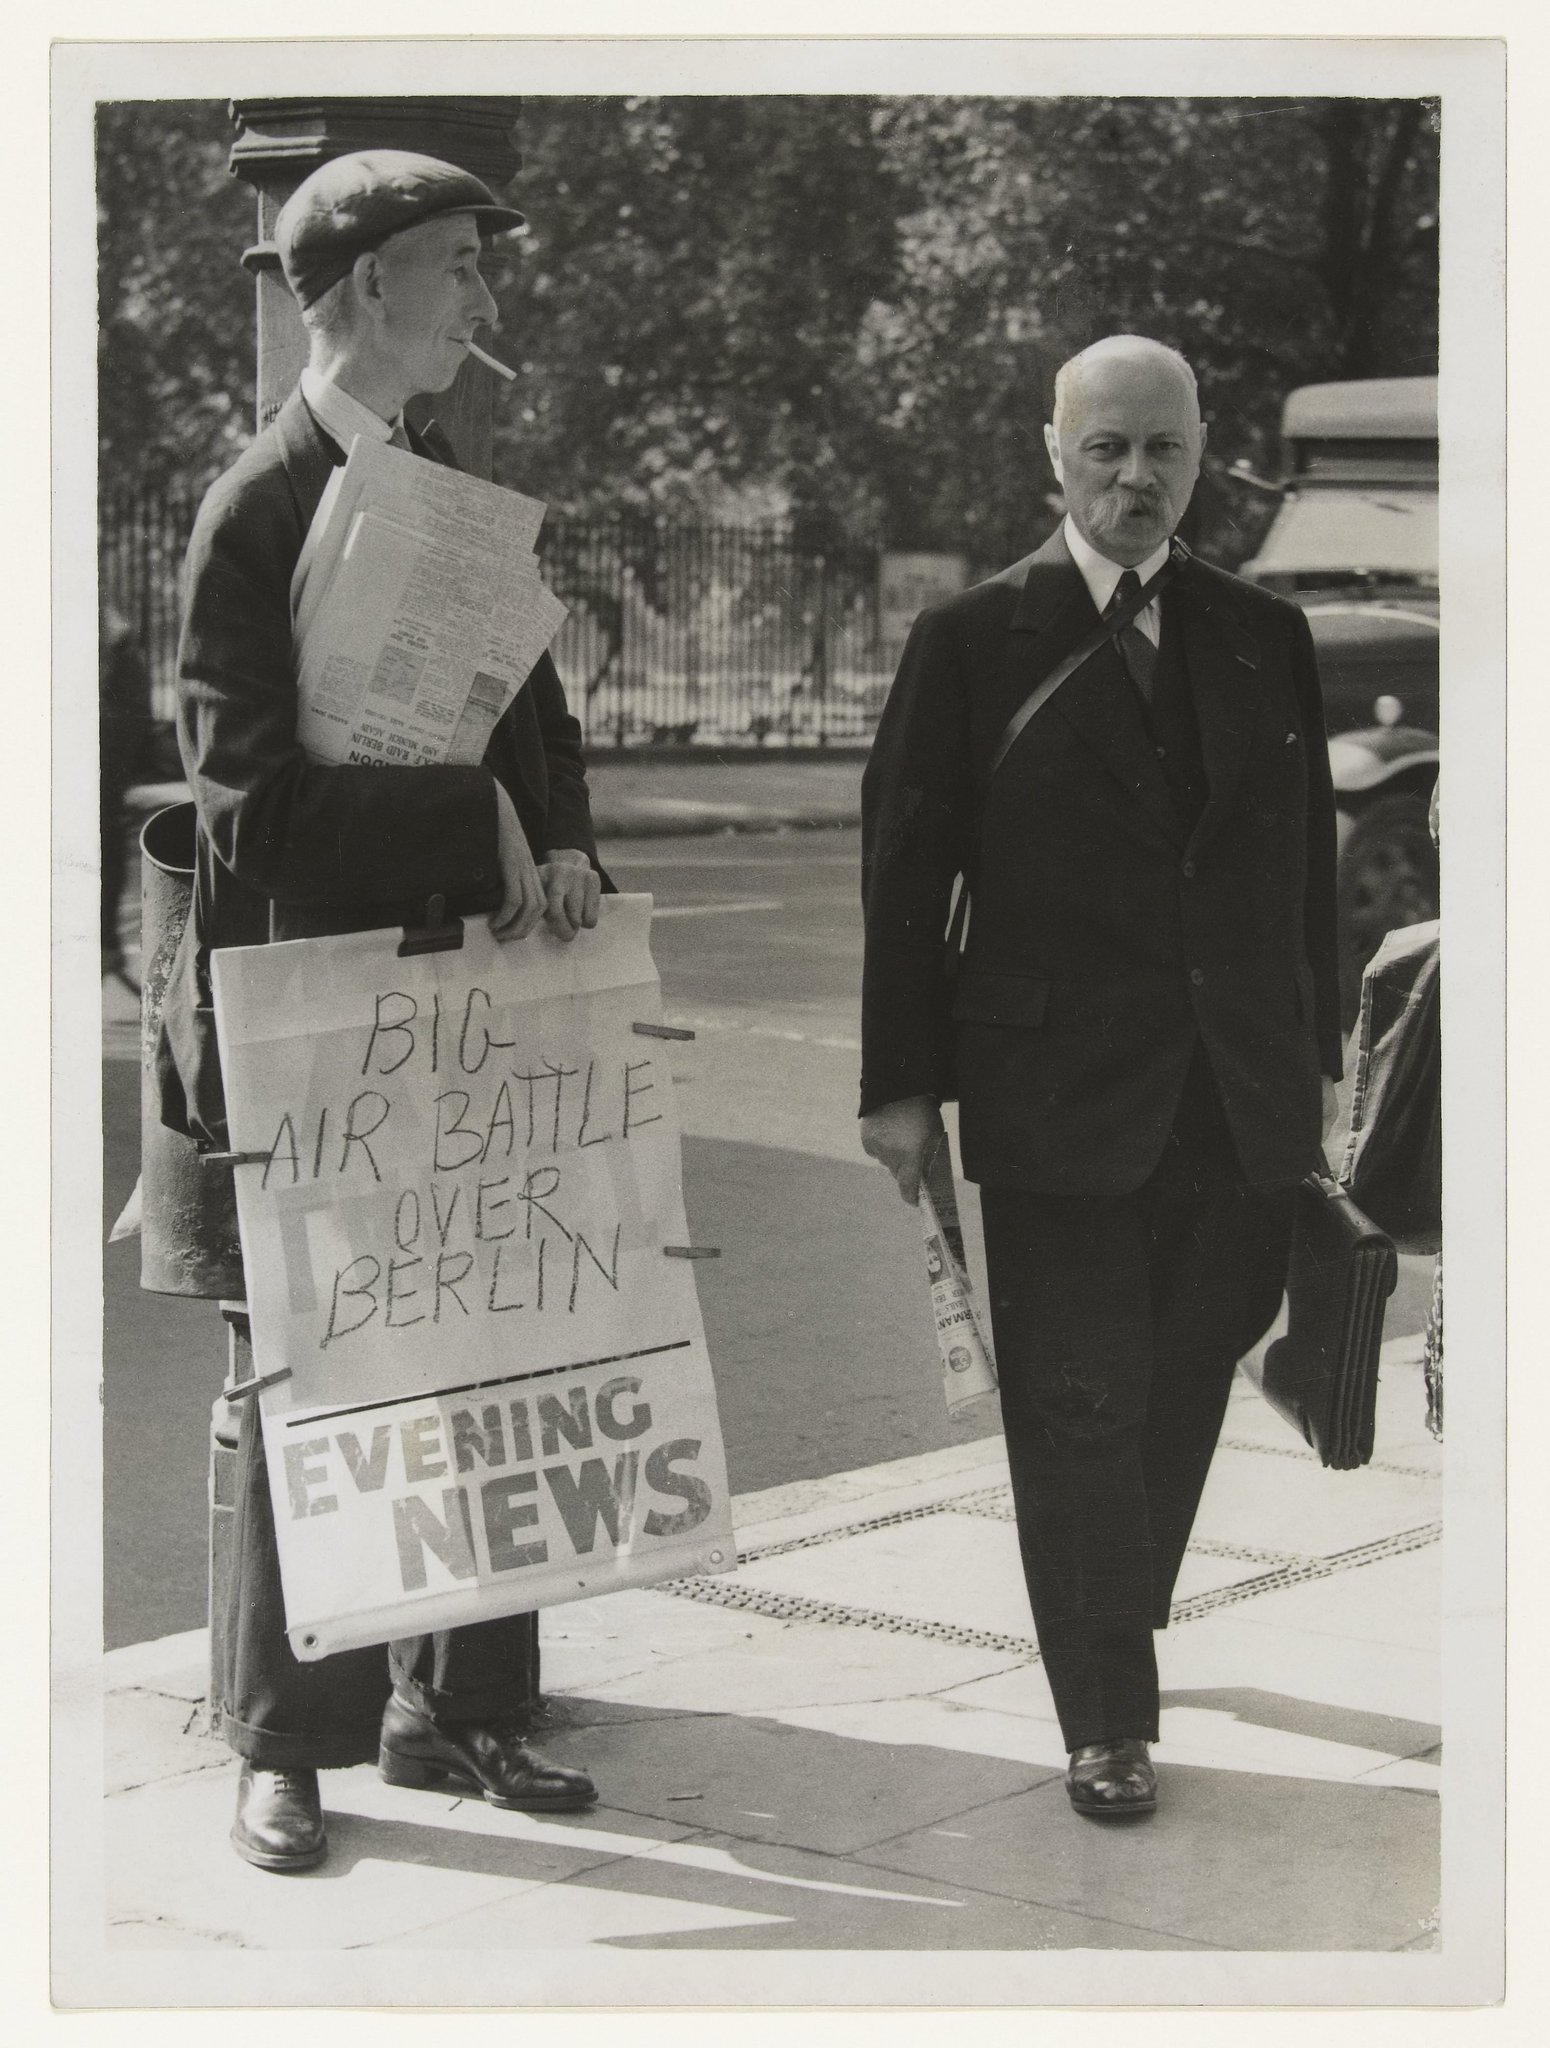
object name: documentary photograph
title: De kersverse premier Pieter Gerbrandy loopt naar het Nederlandse hoofdkwartier in Londen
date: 1940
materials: photographic support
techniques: photography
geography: london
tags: the hague, pieter sjoerds gerbrandy, publisher, london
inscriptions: number: ‘435644’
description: Gerbrandy loopt met een krant in de hand langs Piccadilly in de richting van Stratton House, het Nederlandse hoofdkwartier in Londen met op de achtergrond Hyde Park. Hij passeert een krantenverkoper die een bord vasthoudt met de 'headlines' van die dag: 'Big air battle over Berlin'. Gerbrandy is net één dag eerder benoemd tot minister-president door koningin Wilhelmina. Hij had deze benoeming voornamelijk te danken aan zijn strijdlustige houding met betrekking tot het voortzetten van de strijd tegen de Duitsers; dit in tegenstelling tot zijn voorganger De Geer. Koningin Wilhelmina zegt haar vertrouwen op 26 augustus 1940 jegens deze minister-president op wegens zijn weinig strijdlustige houding.